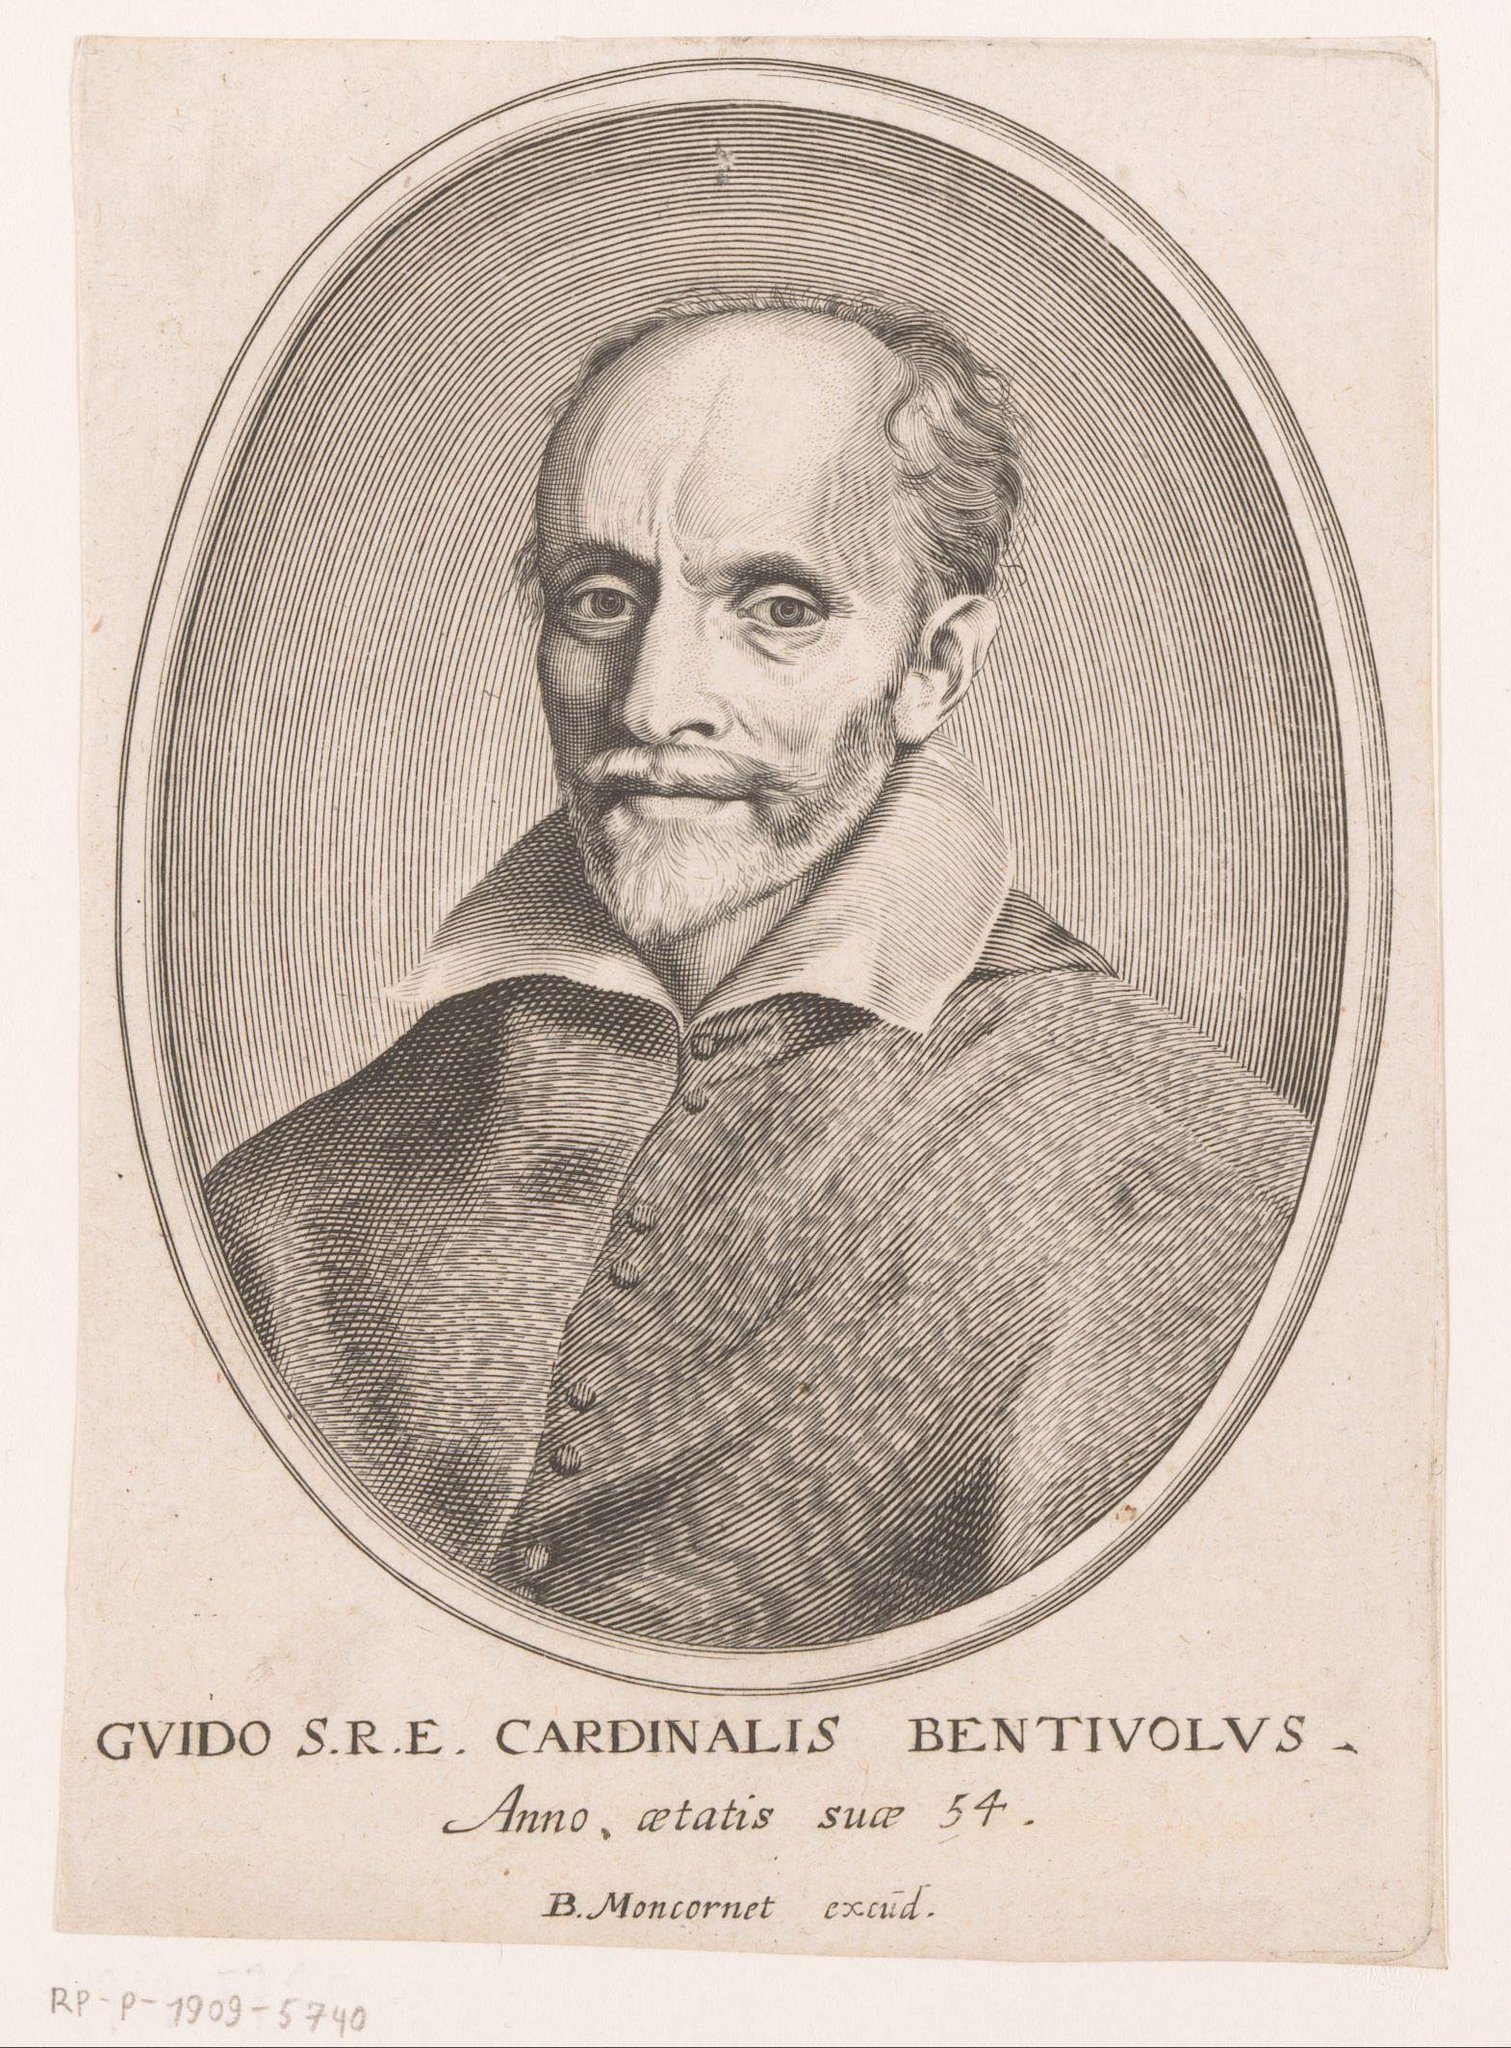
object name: print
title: Portret van Guido Bentivoglio op 54-jarige leeftijd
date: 1610-1668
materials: paper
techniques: engraving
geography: paris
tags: rome, politician, cardinal, historical persons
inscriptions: collector's mark: Lugt 2228